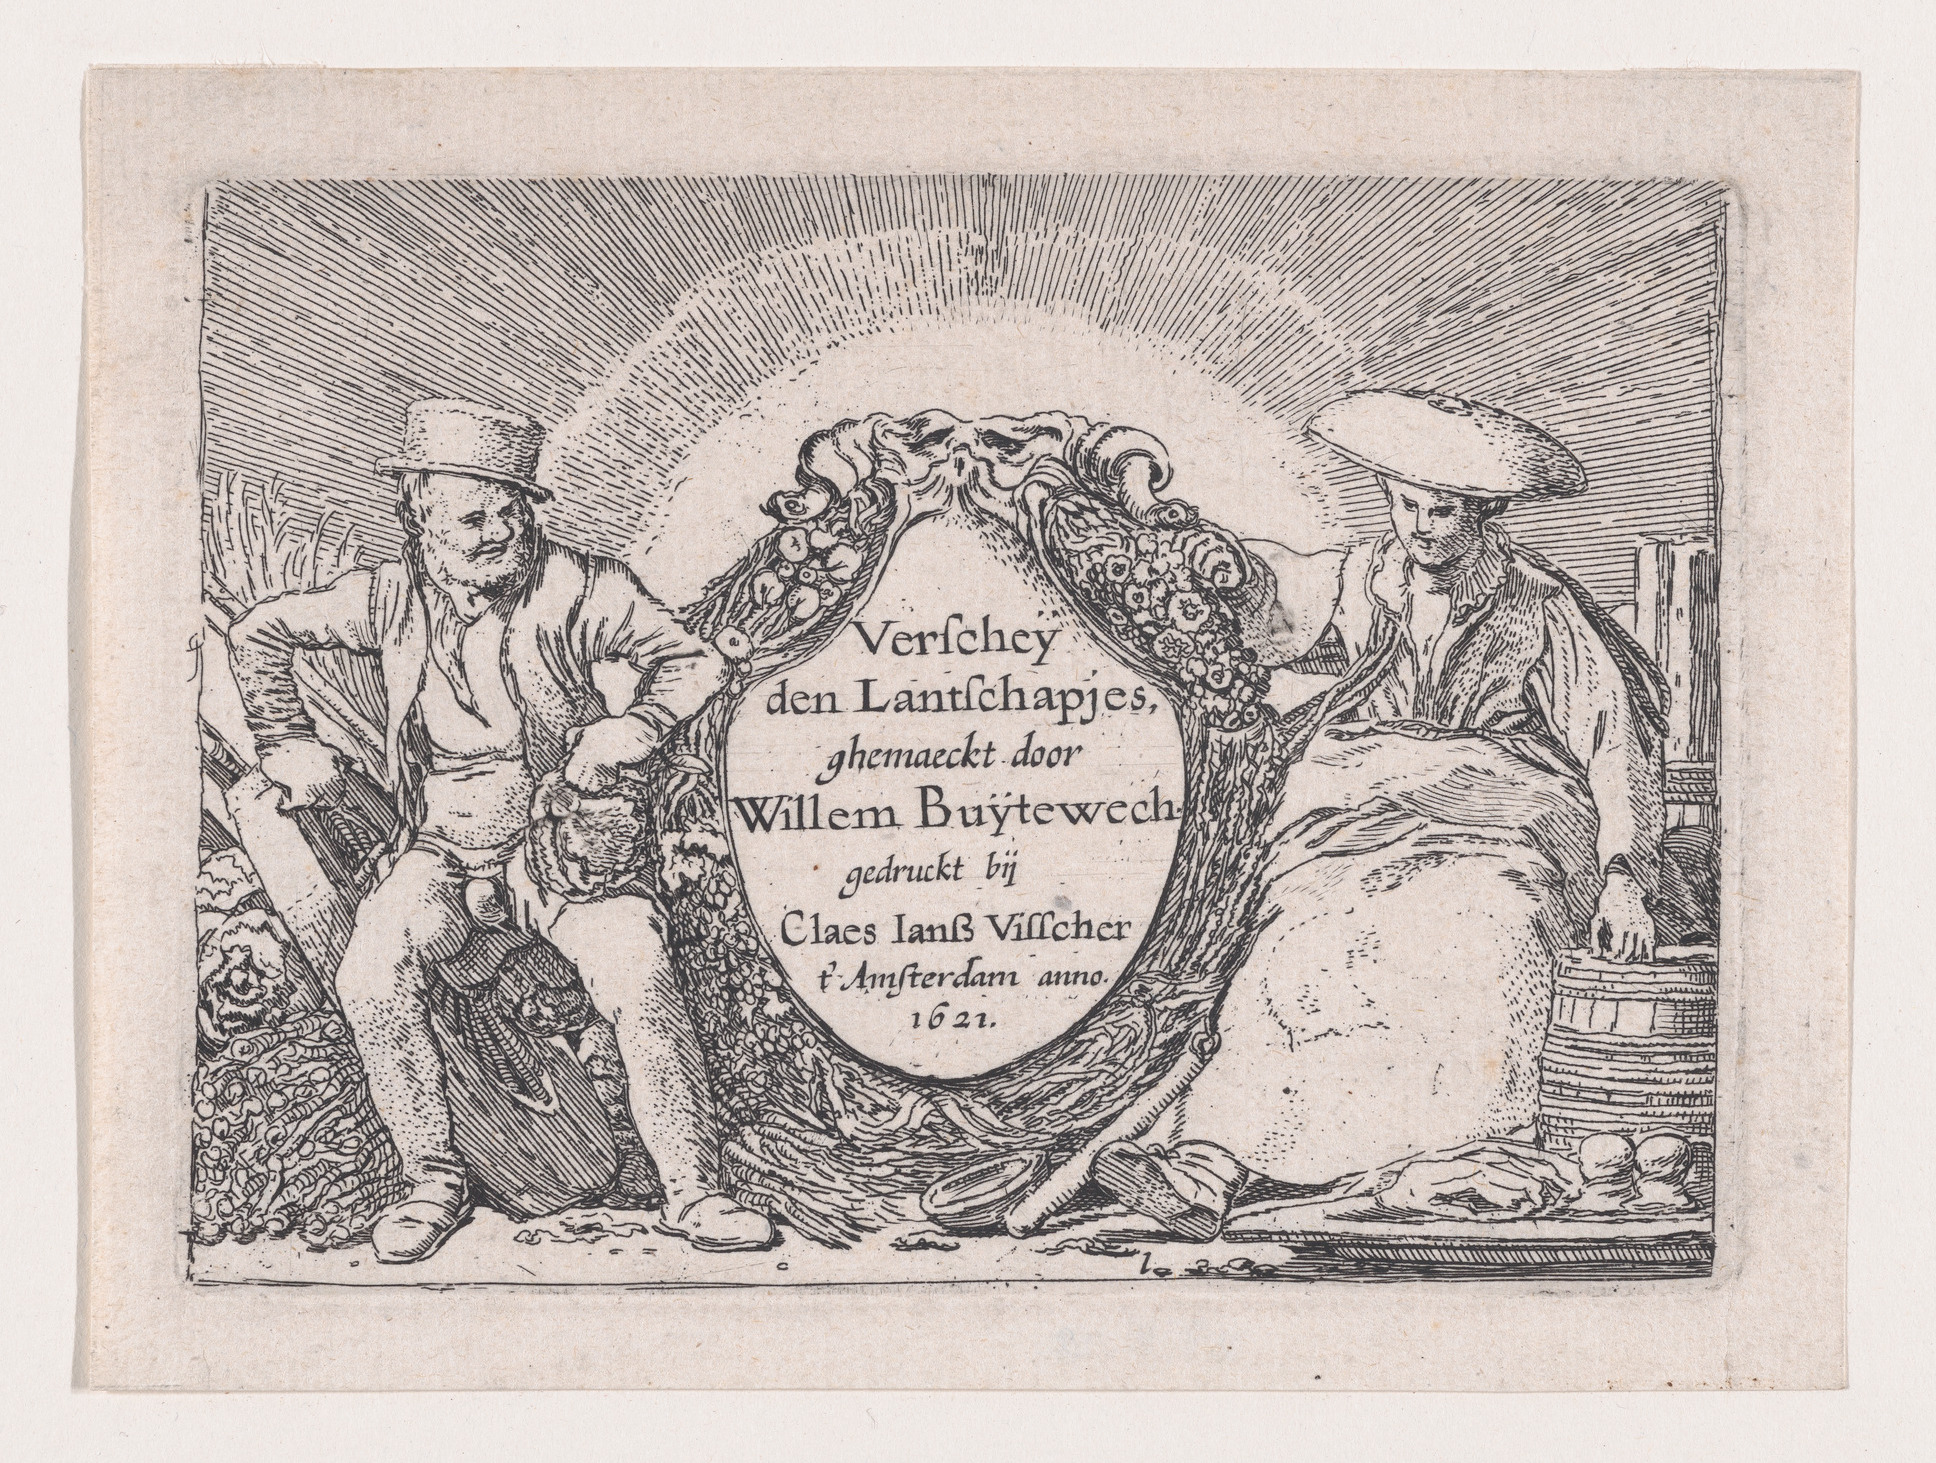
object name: print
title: Titlepage, from Verscheyden Landtschapjes (Various Little Landscapes), Plate 1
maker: willem pietersz buytewech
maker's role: artist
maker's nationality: dutch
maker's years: 1591-1624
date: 1616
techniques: etching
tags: men,women